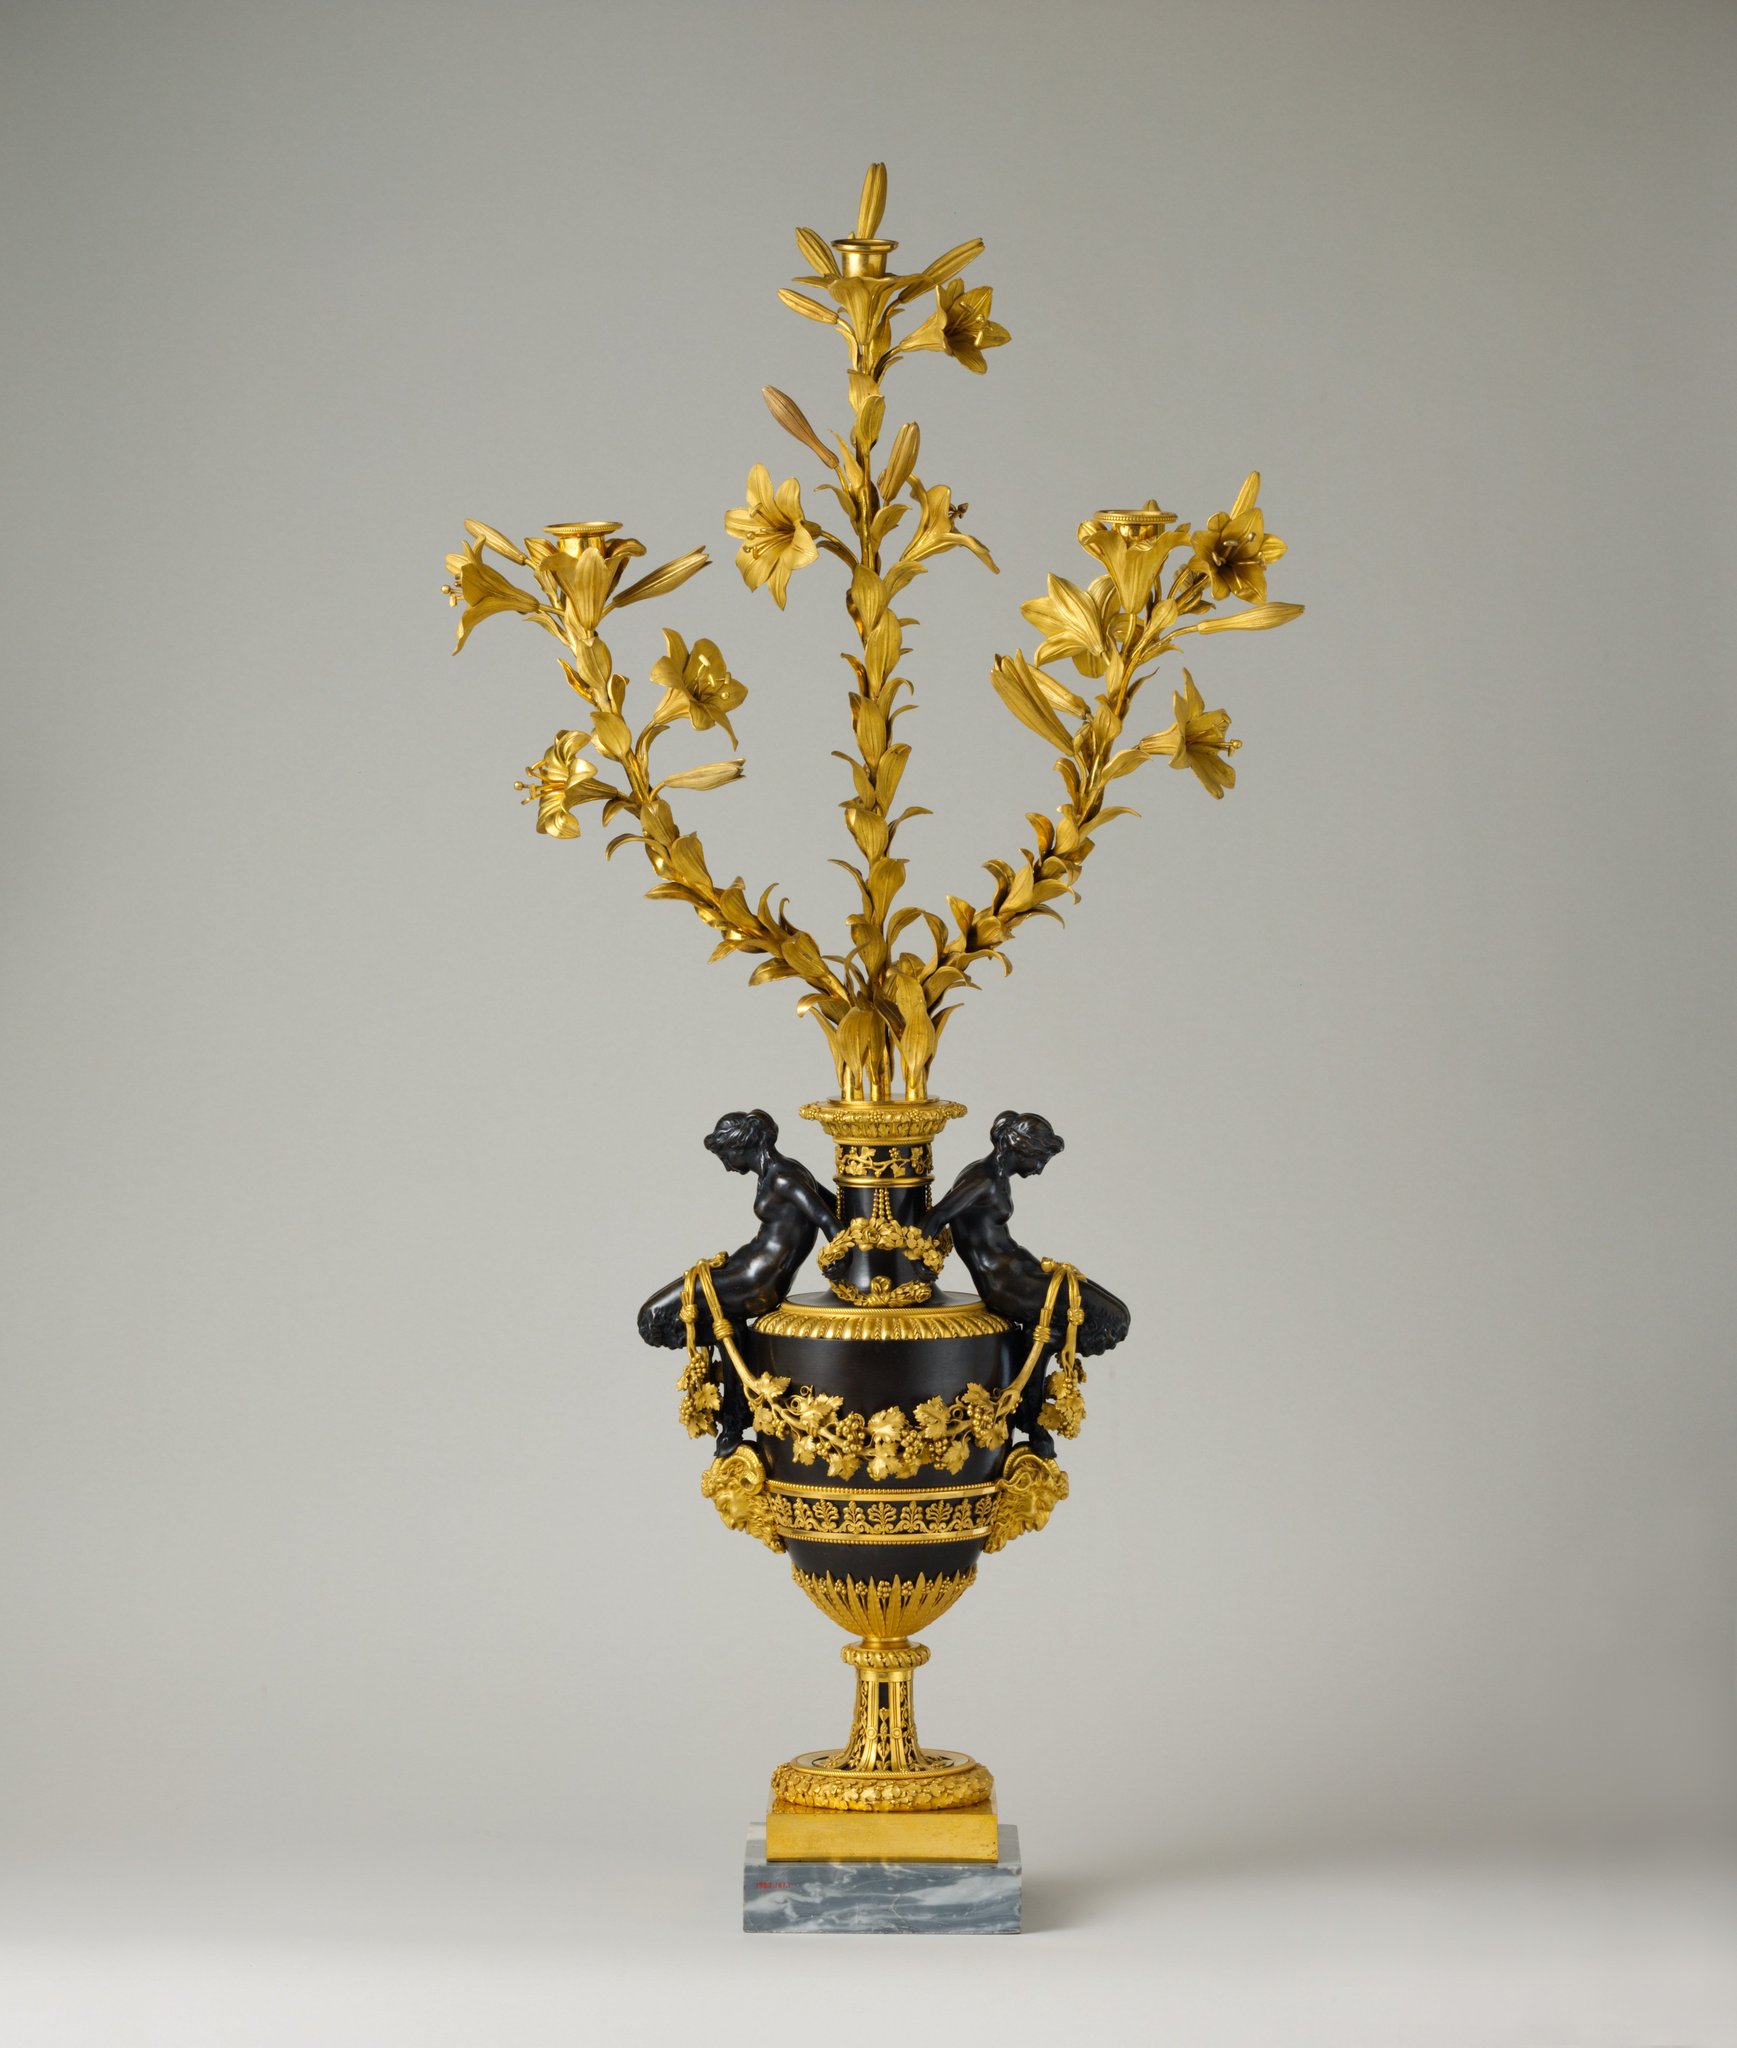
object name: candelabrum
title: Three-light candelabrum (one of a pair)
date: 1785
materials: bronze, gilt bronze, marble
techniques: enamel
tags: female nudes,flowers